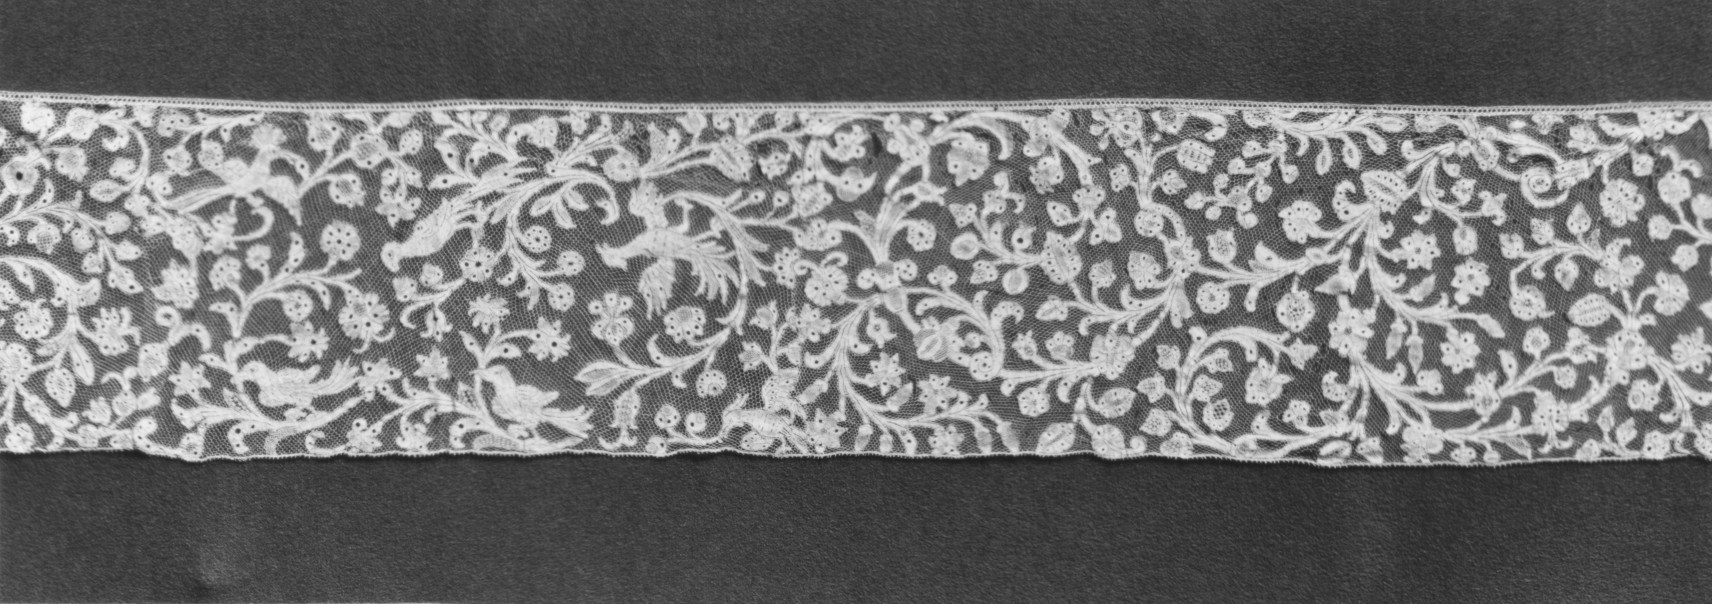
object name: border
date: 1667-1700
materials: lace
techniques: lace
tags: birds,flowers